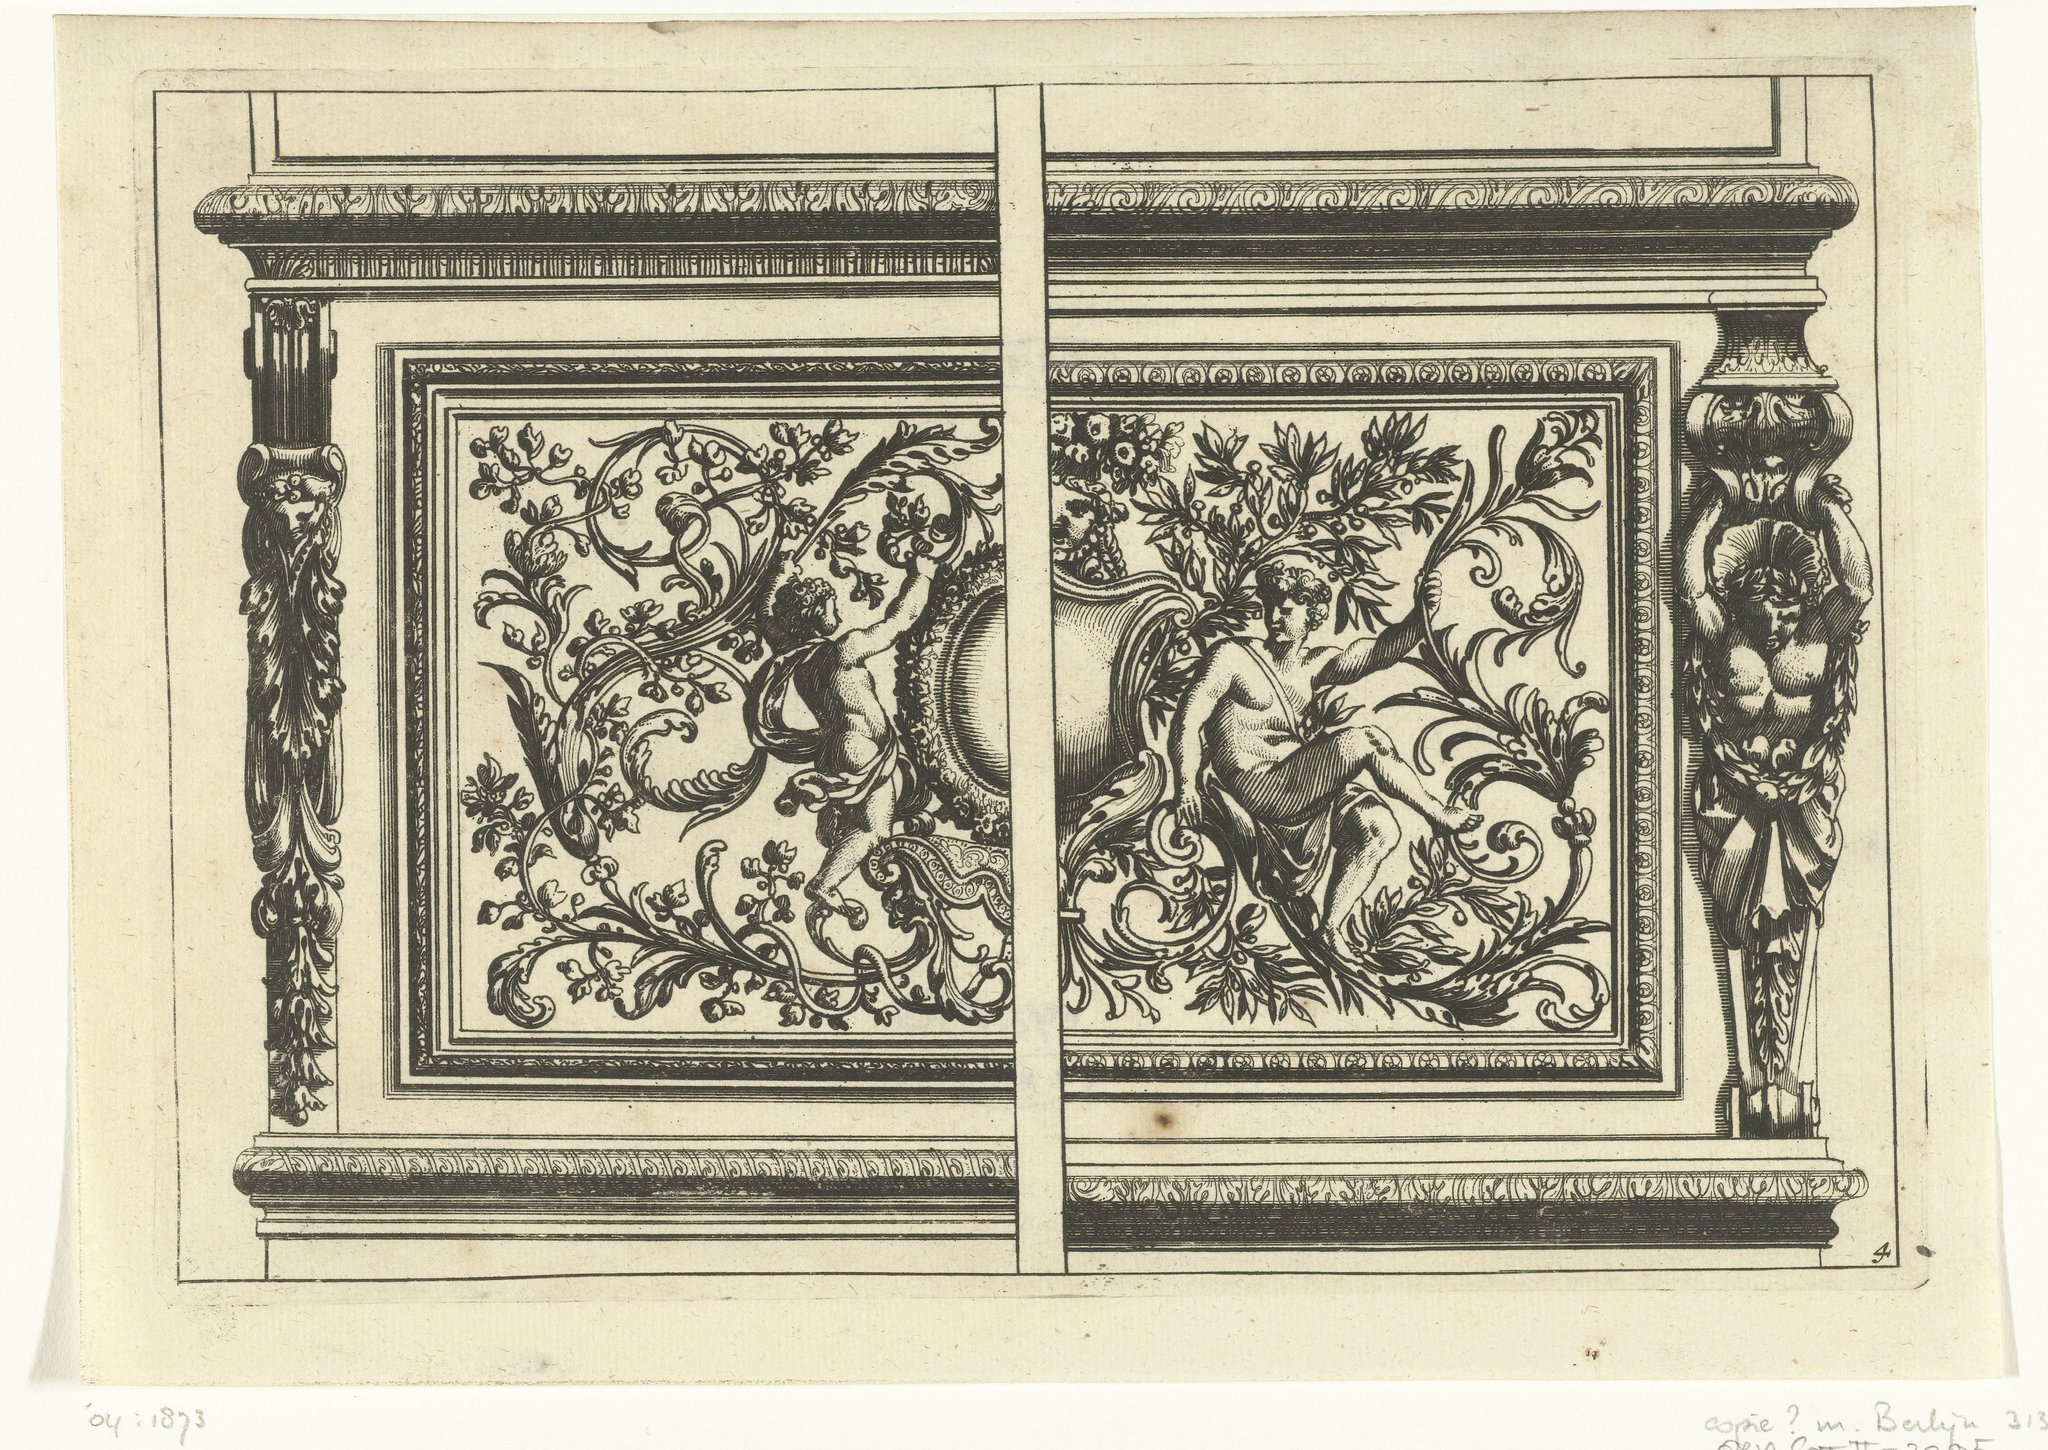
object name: print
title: New Designs for Ornamenting and Embellishing Coaches and Carriages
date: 1680-1701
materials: paper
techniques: etching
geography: amsterdam